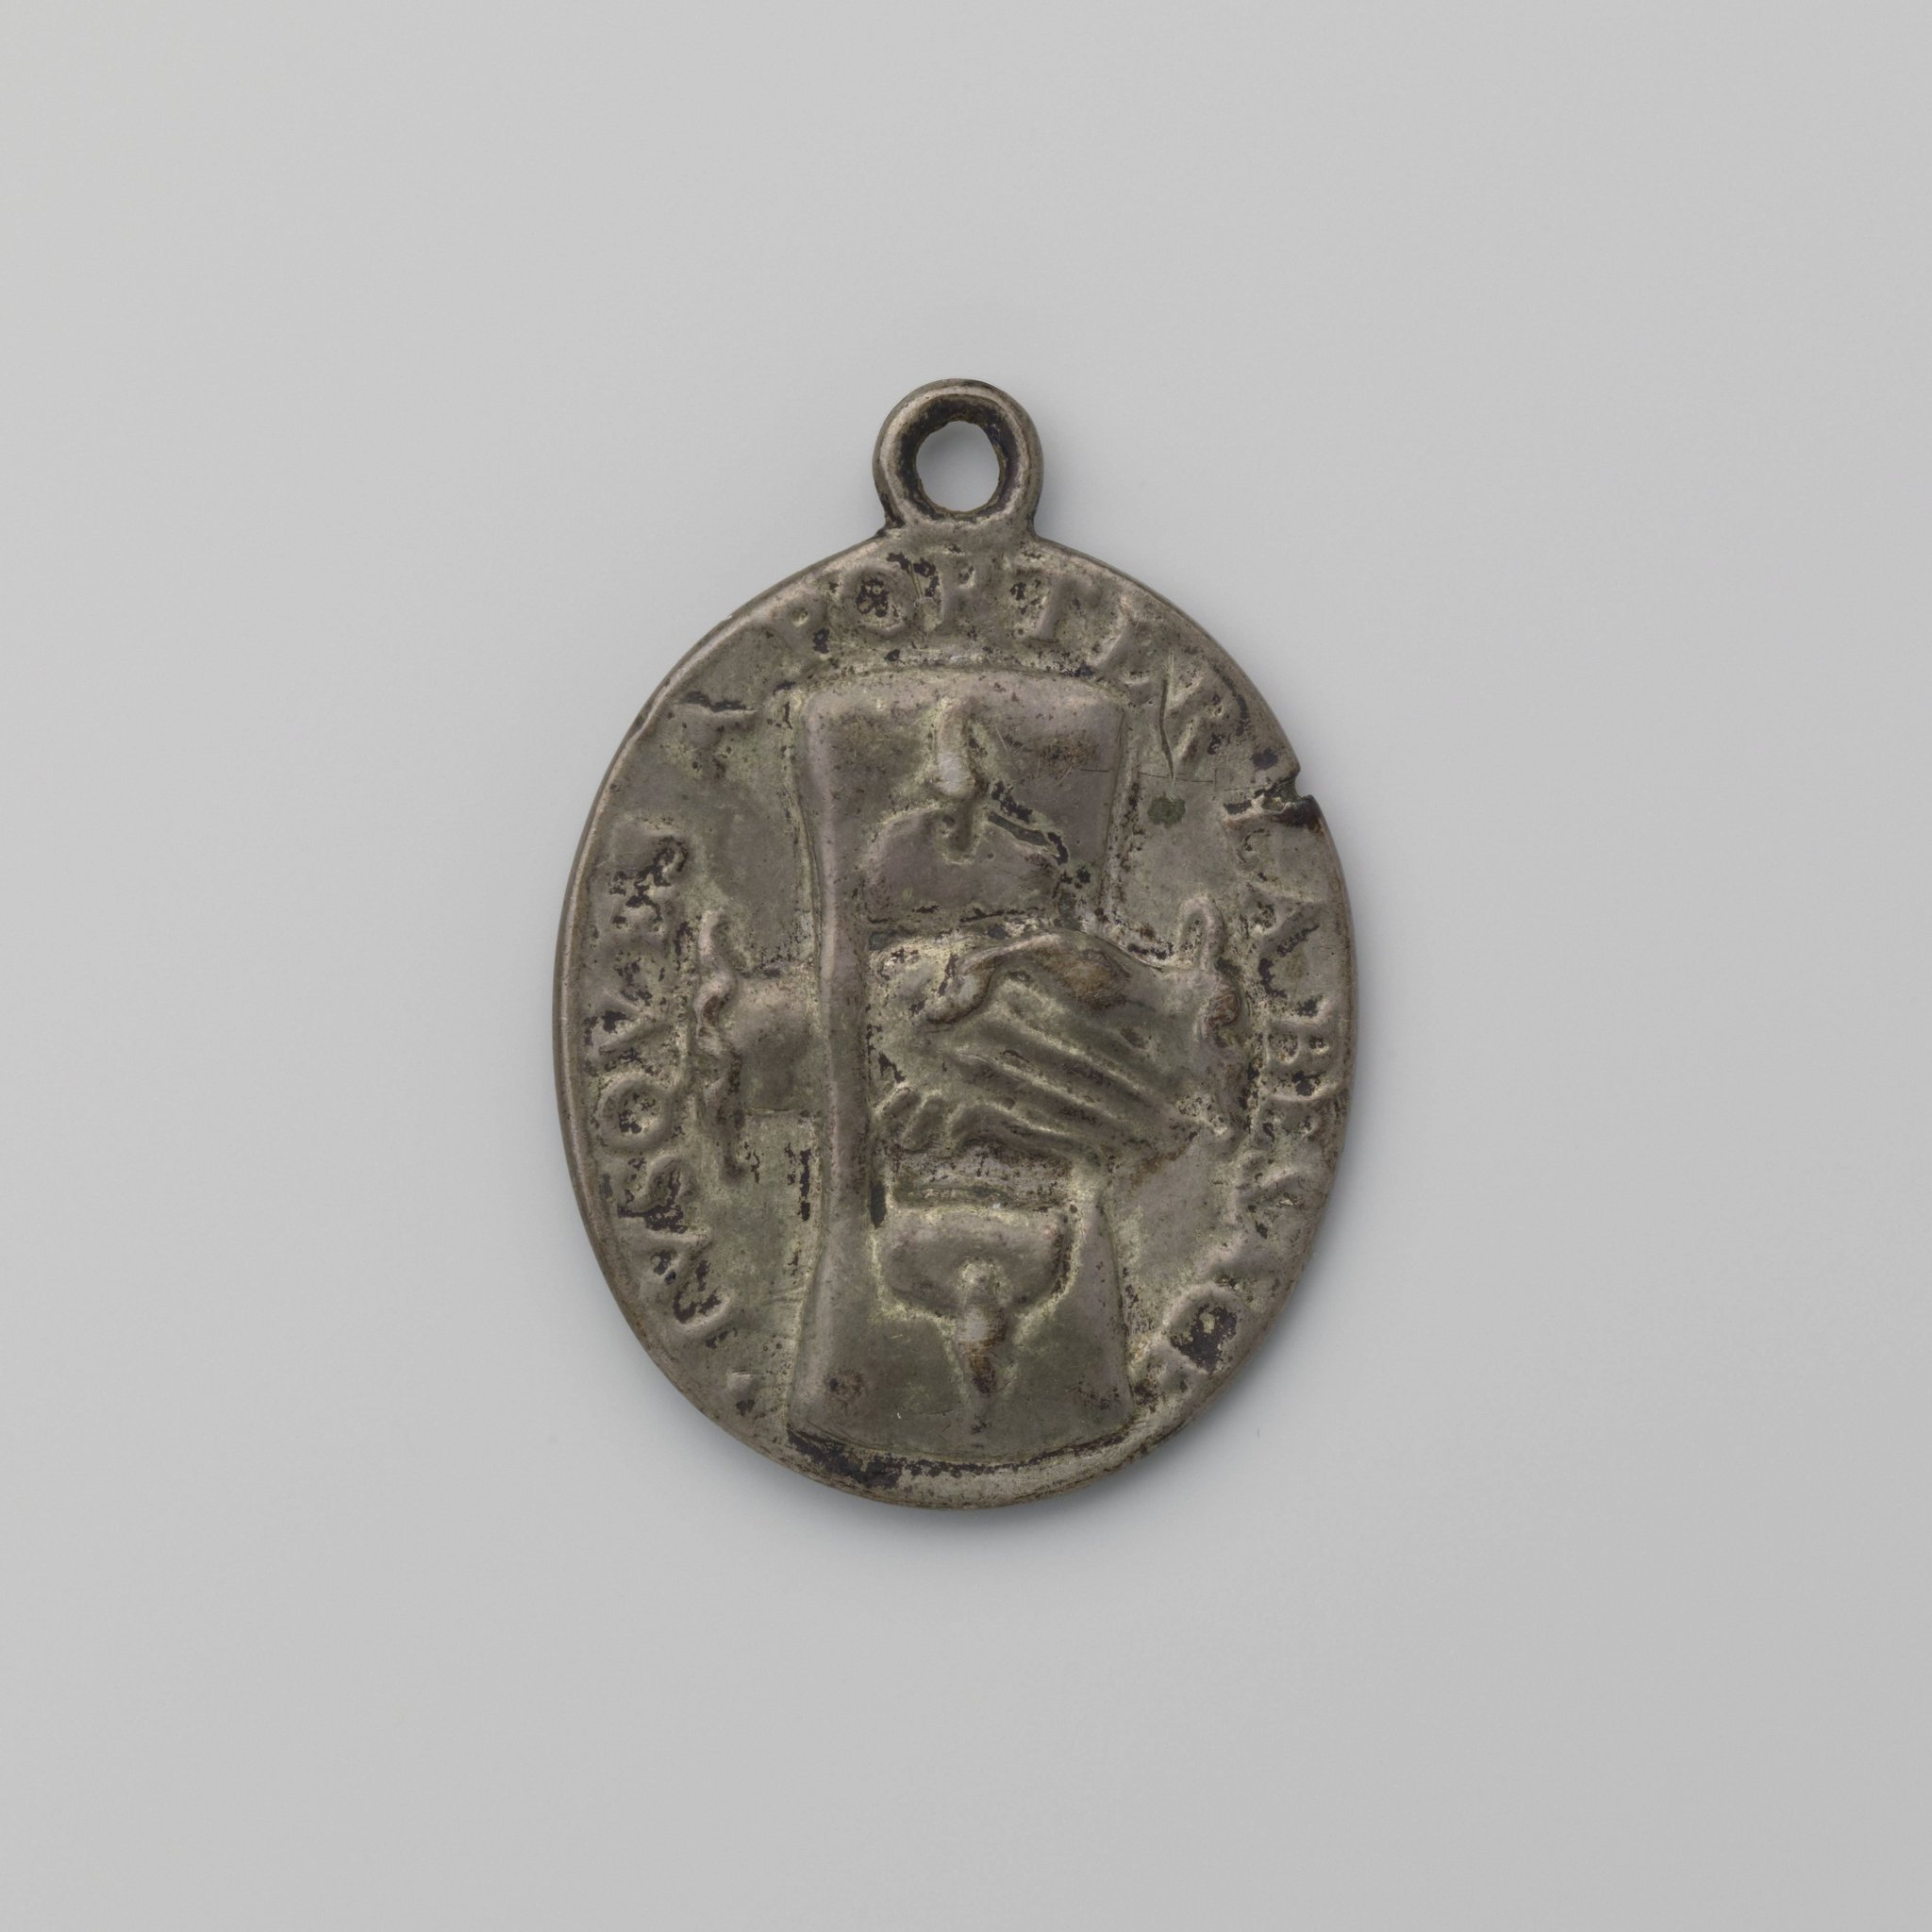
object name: beggar's medal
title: Beggars’ Medal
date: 1566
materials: silver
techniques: casting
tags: philip ii of spain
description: Zilveren ovale penning met draagoog. Voorzijde: borststuk man binnen omschrift. Keerzijde: twee ineen geslagen handen door een bedelzak gestoken binnen omschrift.